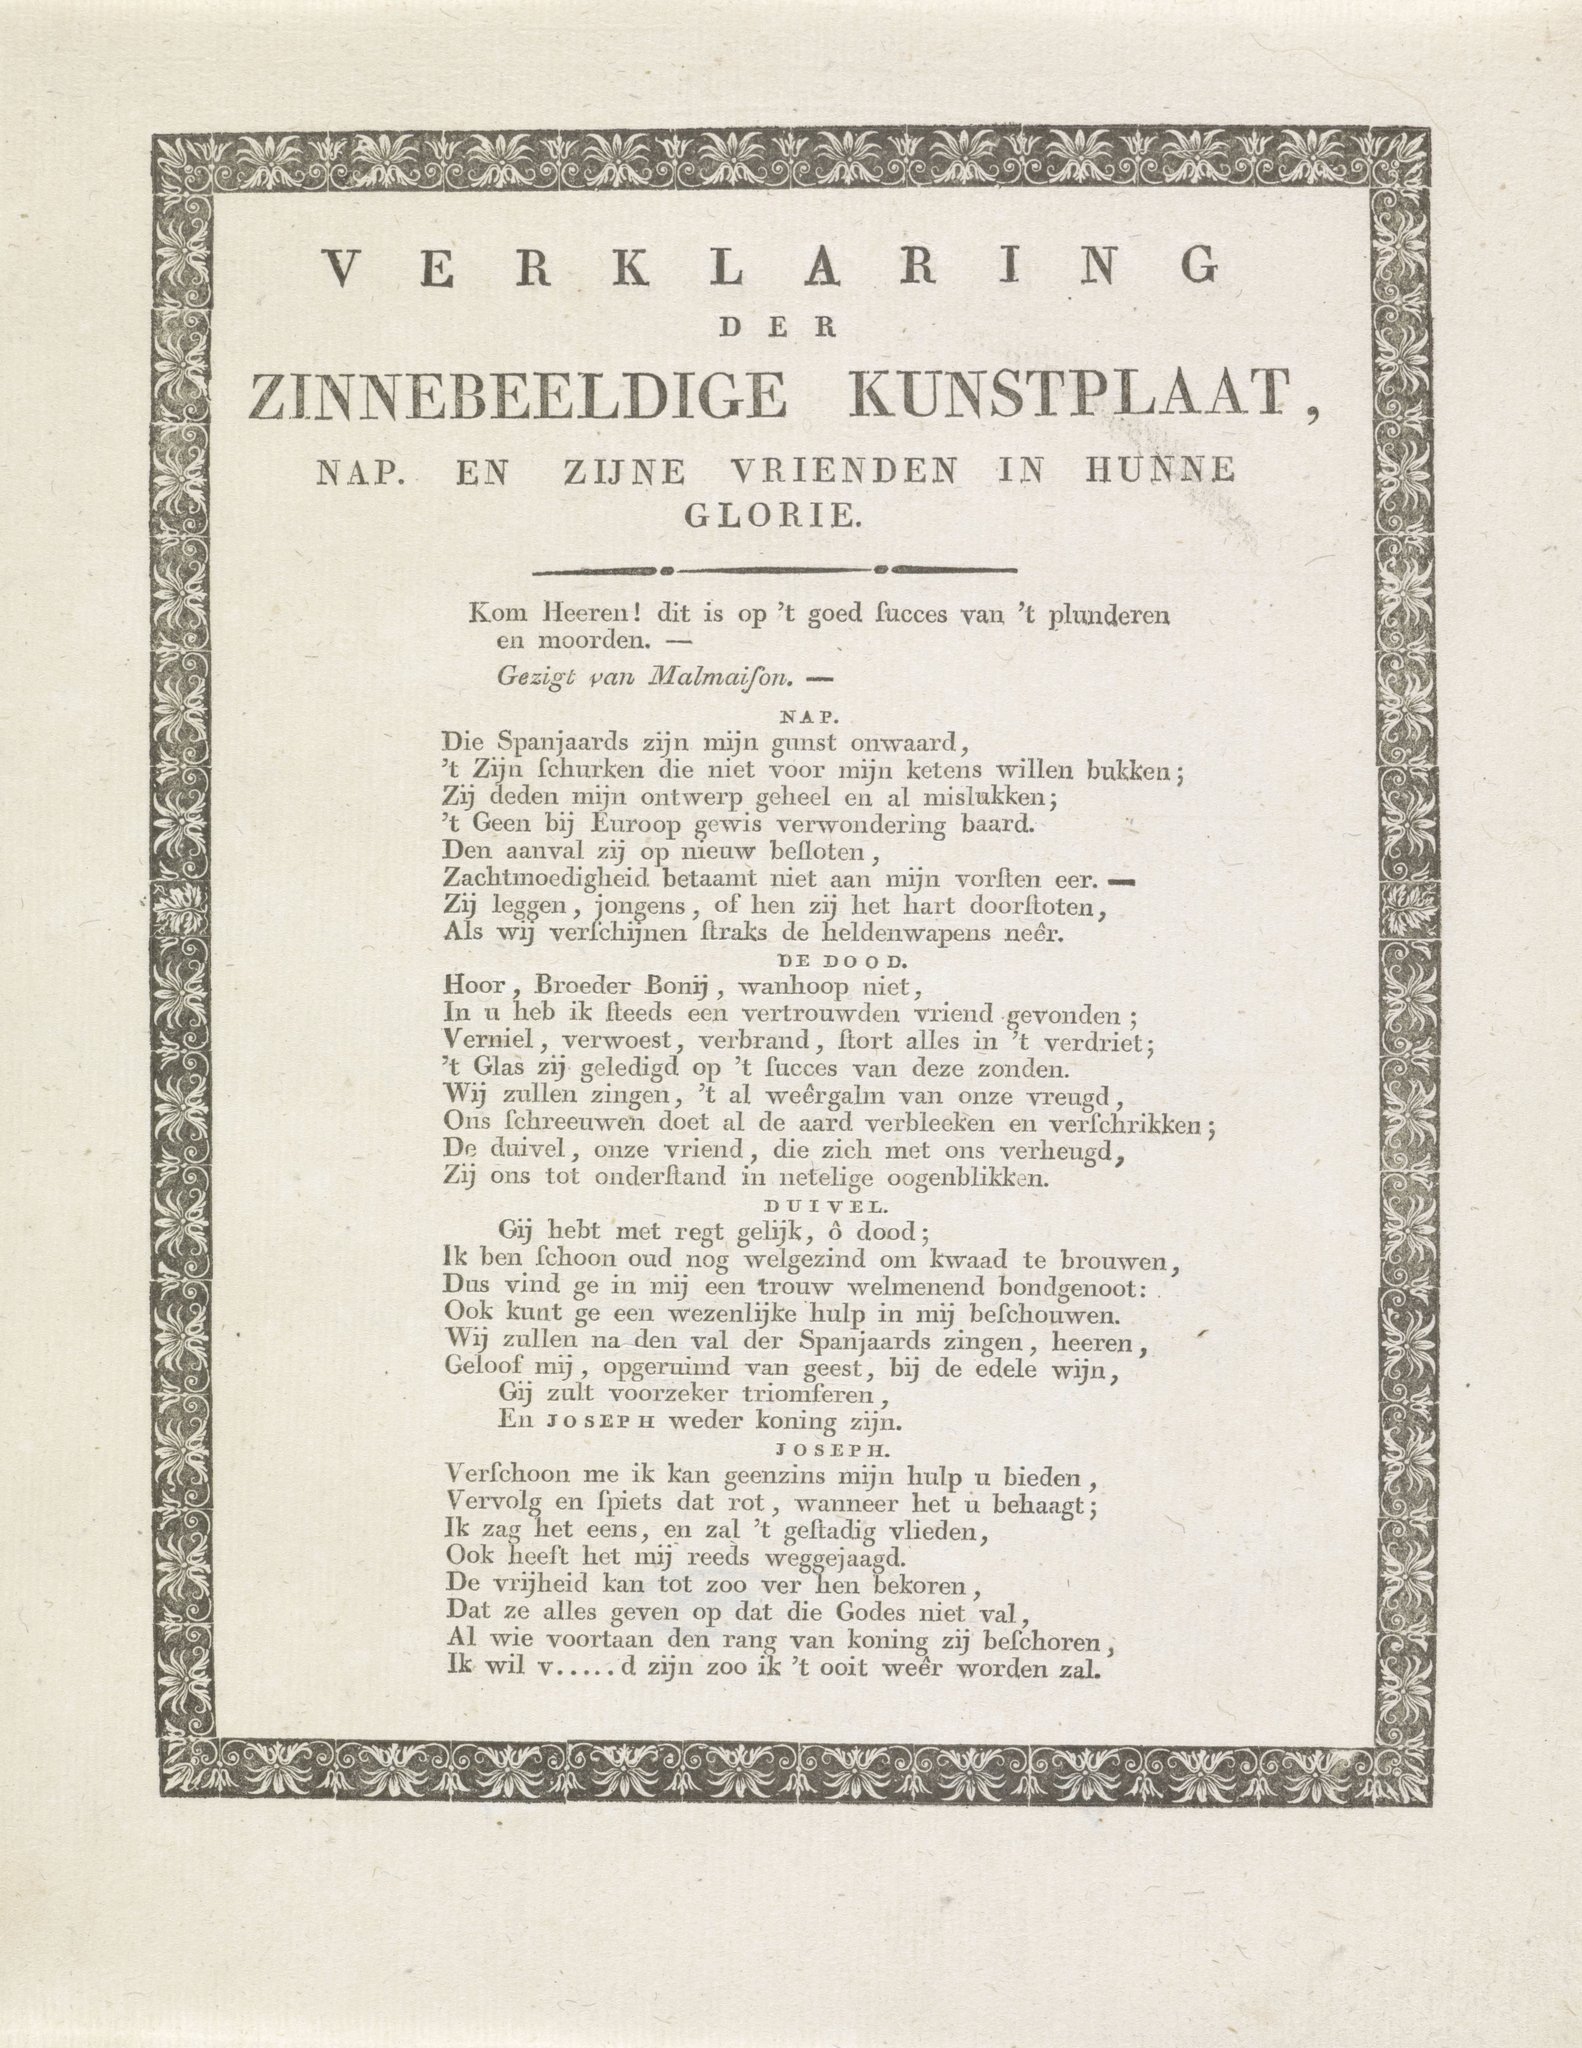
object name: print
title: Verklaring bij de spotprent op Napoleon en zijn vrienden in hun glorie, 1813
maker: Anonymous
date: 1813-1814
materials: paper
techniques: letterpress printing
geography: netherlands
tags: napoleon i (emperor of the french), banquet of elegant company (+ toast at meal, banquet), death as skeleton, devil(s) and demons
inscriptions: collector's mark: Lugt 2228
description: Gedrukte verklaring van de spotprent op Napoleon die aan een tafel zit met zijn broer Jozef, de Dood en de Duivel en met de anderen wil drinken op het succes van plundering en moord. Tekst in vier coupletten namens de vier hoofdpersonen in de voorstelling.